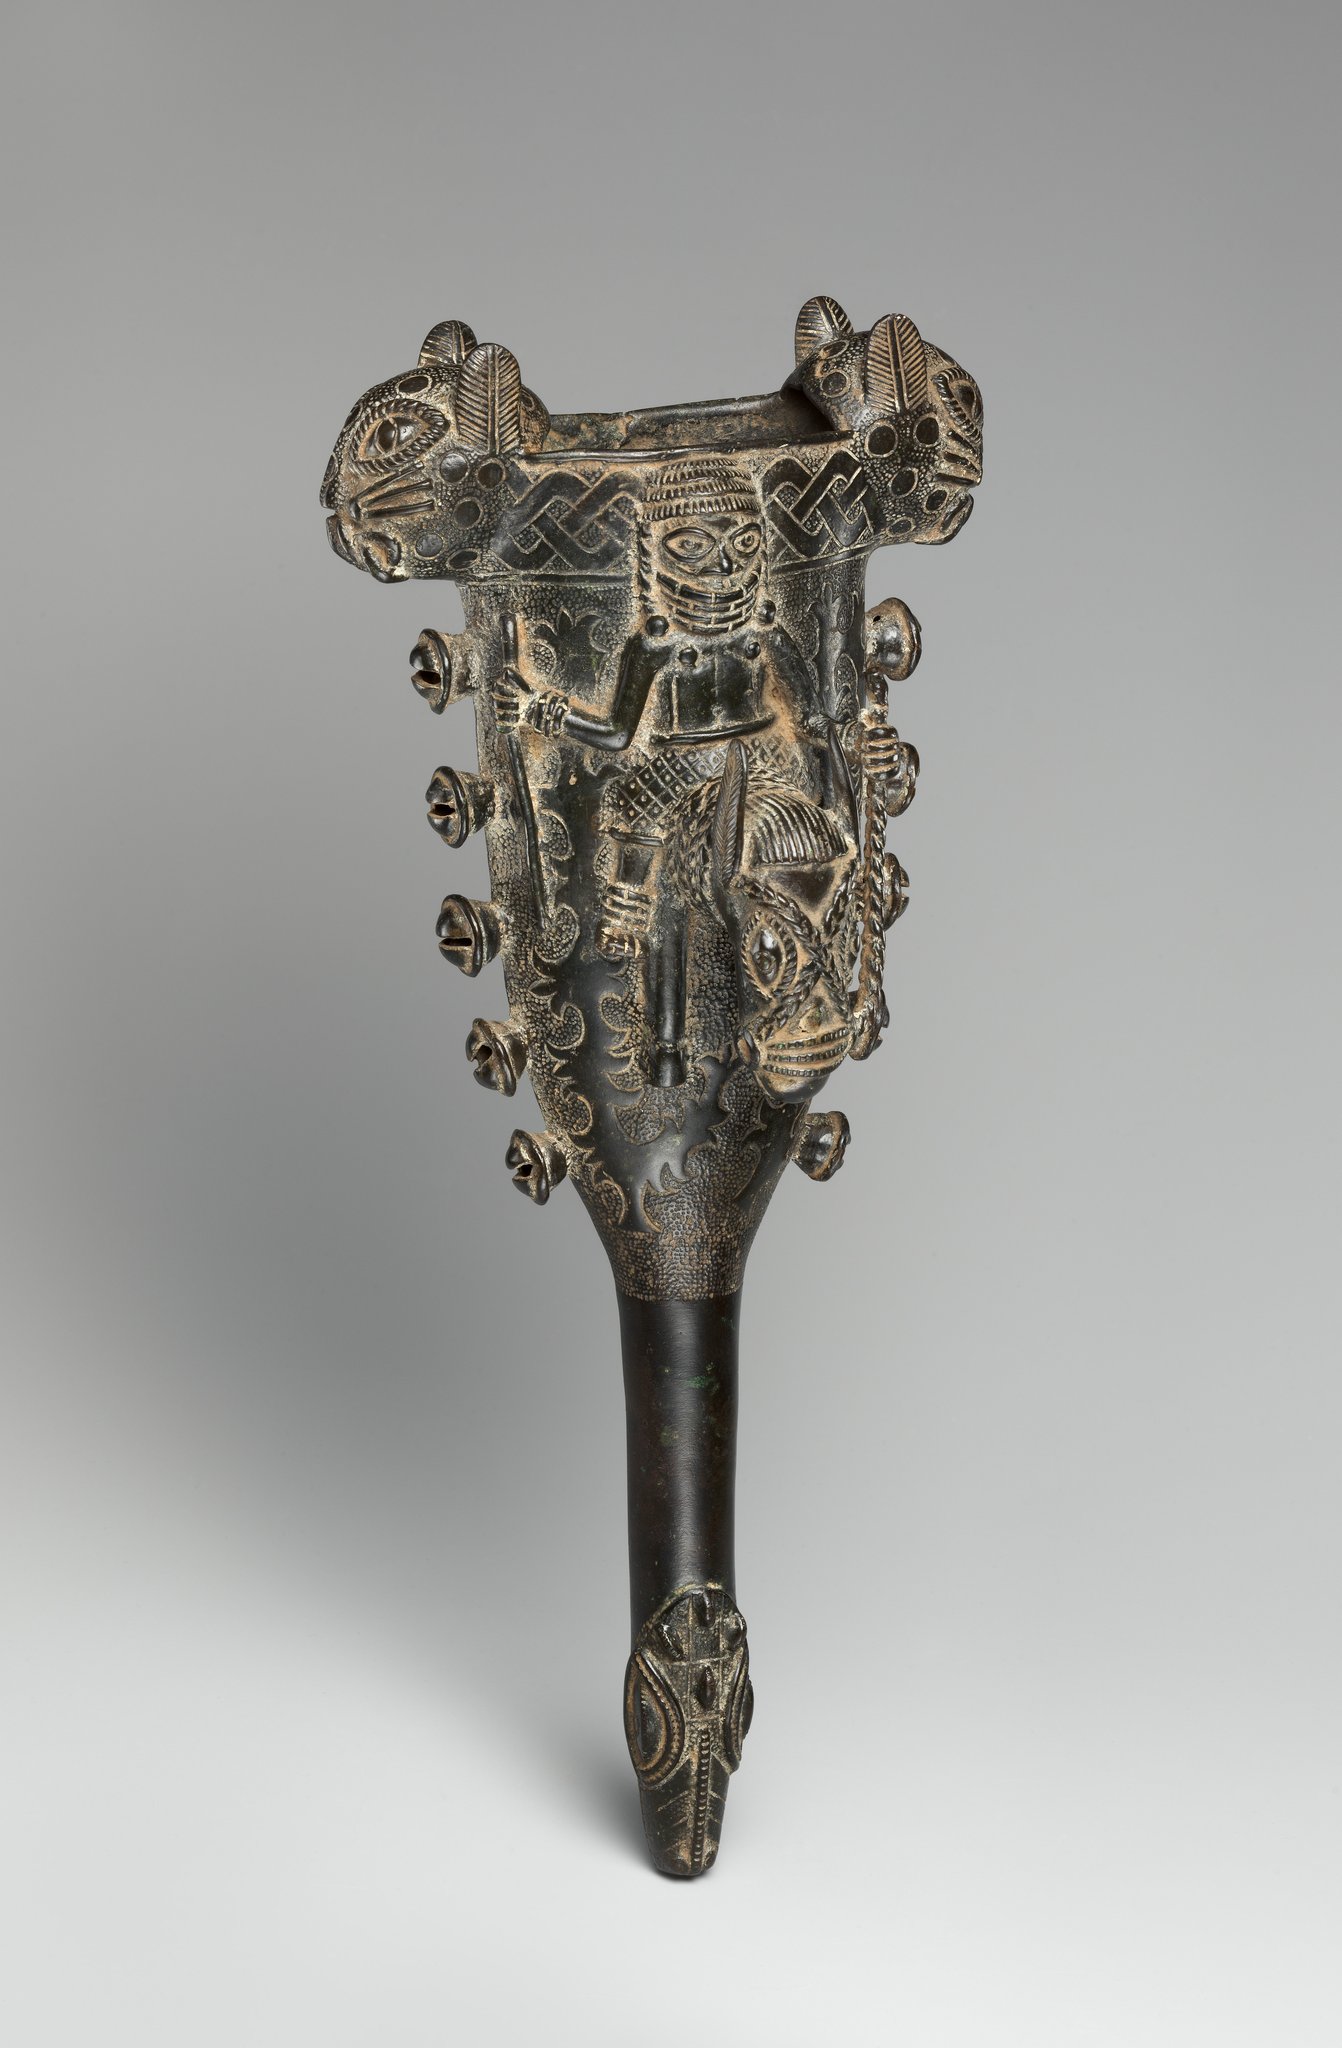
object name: bell ekure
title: Bell (Ekure)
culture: edo period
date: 1801-1866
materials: brass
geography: nigeria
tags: men,horses,leopards